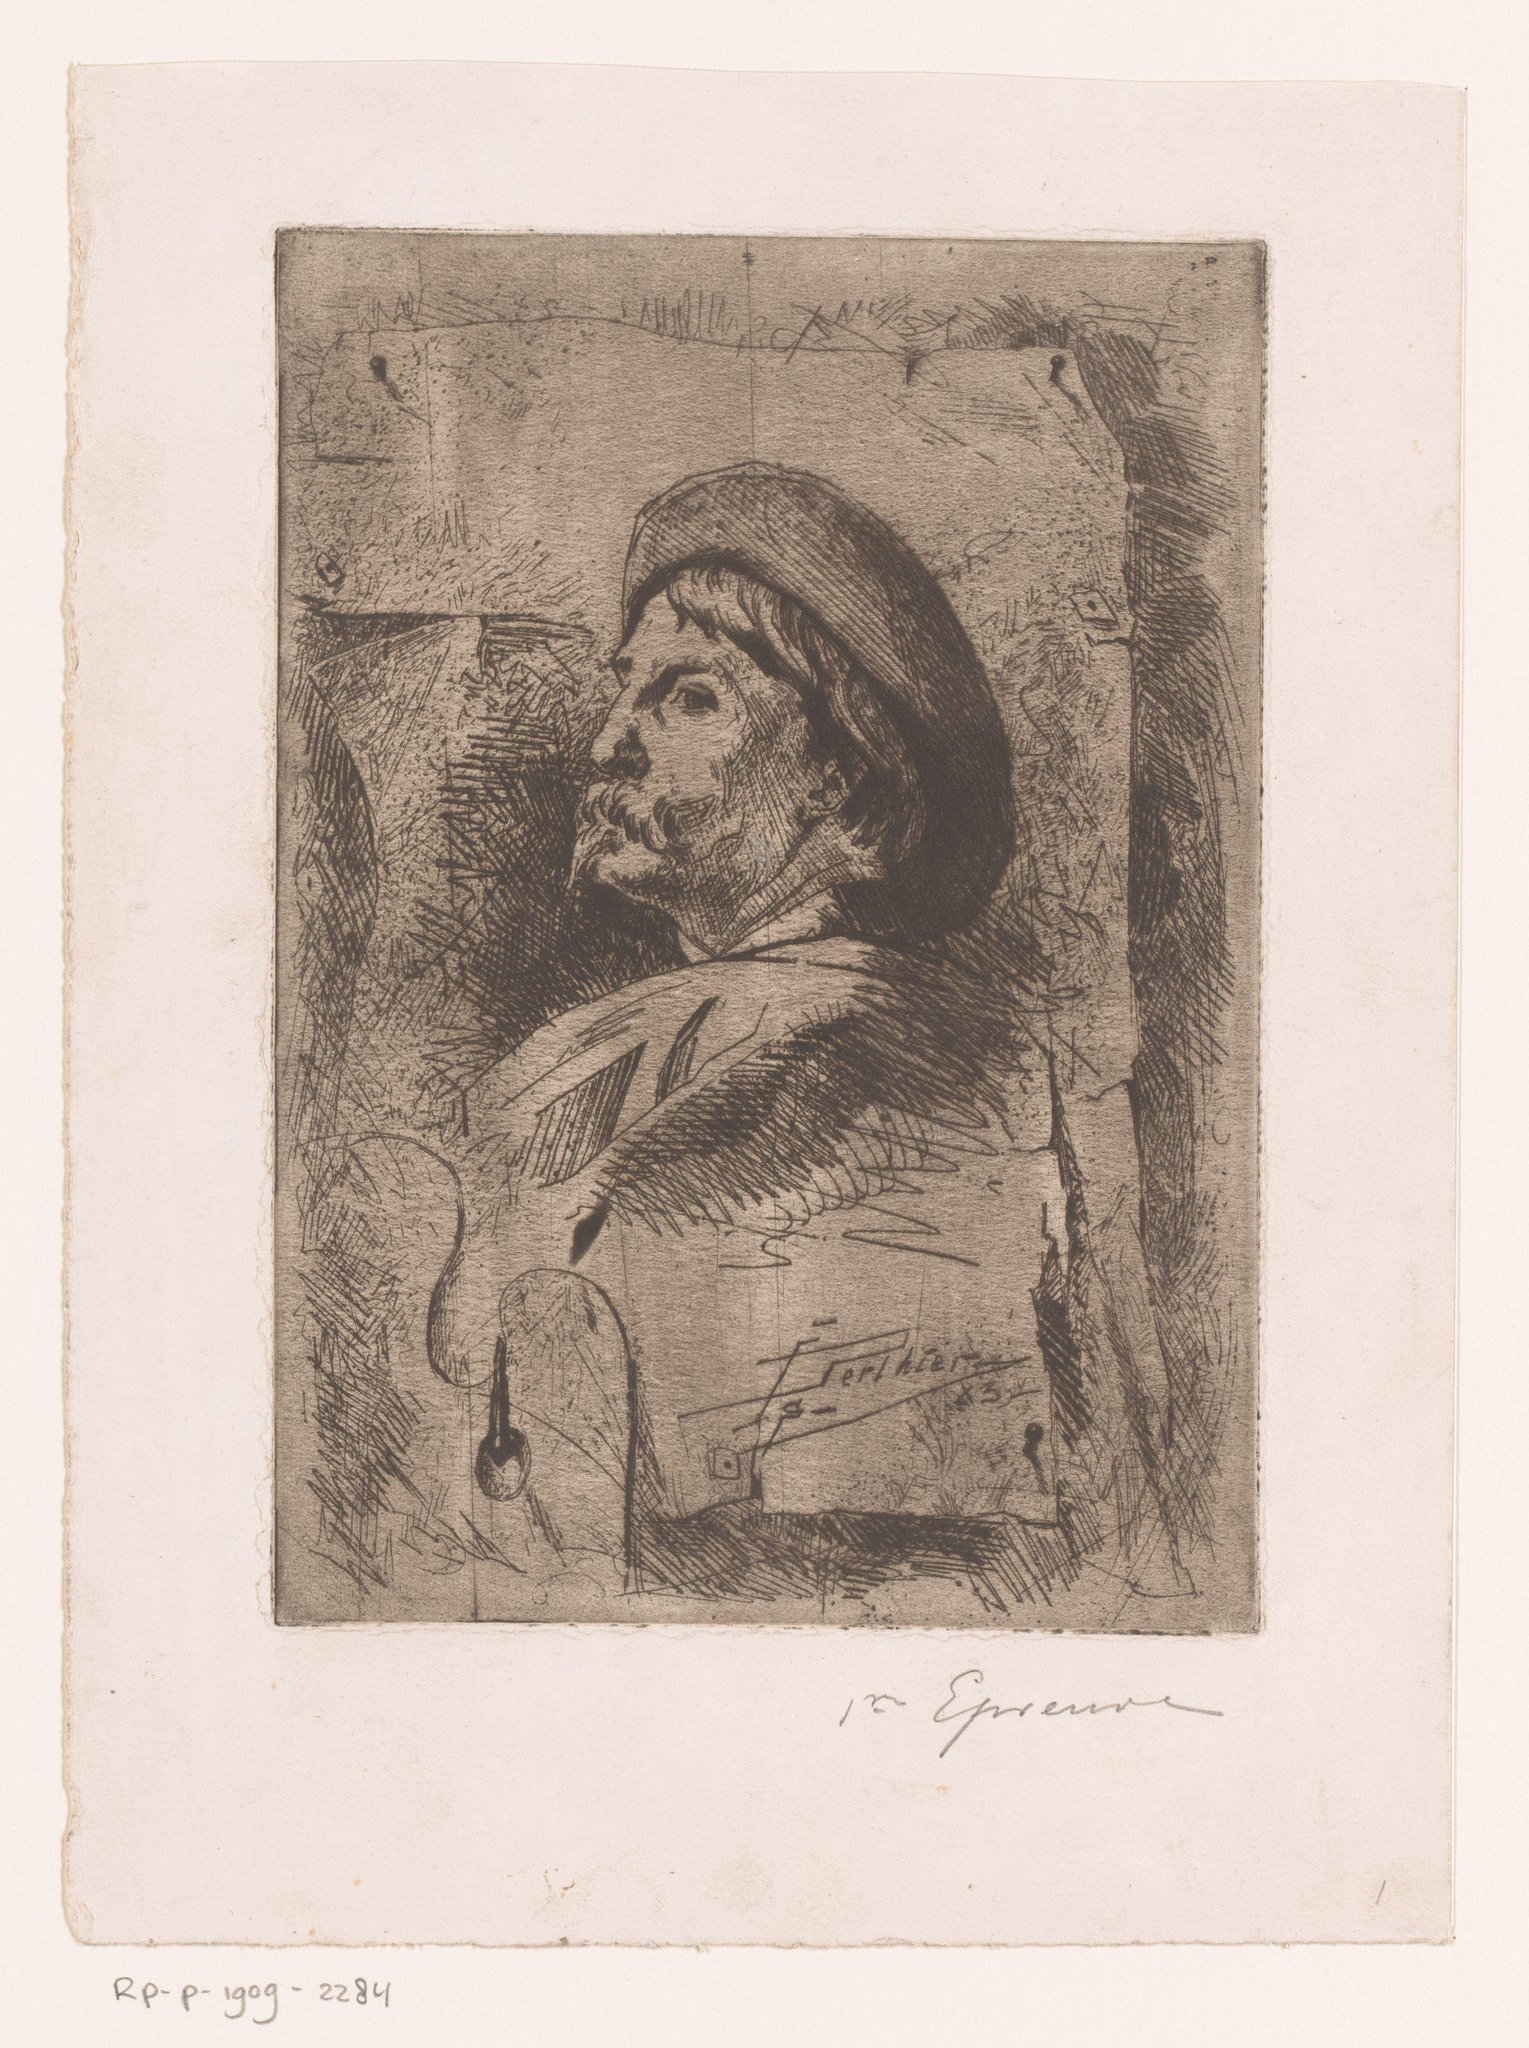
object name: print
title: Portret van een onbekende schilder met baret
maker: h. berthier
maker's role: print maker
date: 1903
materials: paper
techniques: drypoint, etching, intaglio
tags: historical persons, portrait, self-portrait of painter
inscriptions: inscription: ‘1nr Epreuve’, collector's mark: Lugt 2228